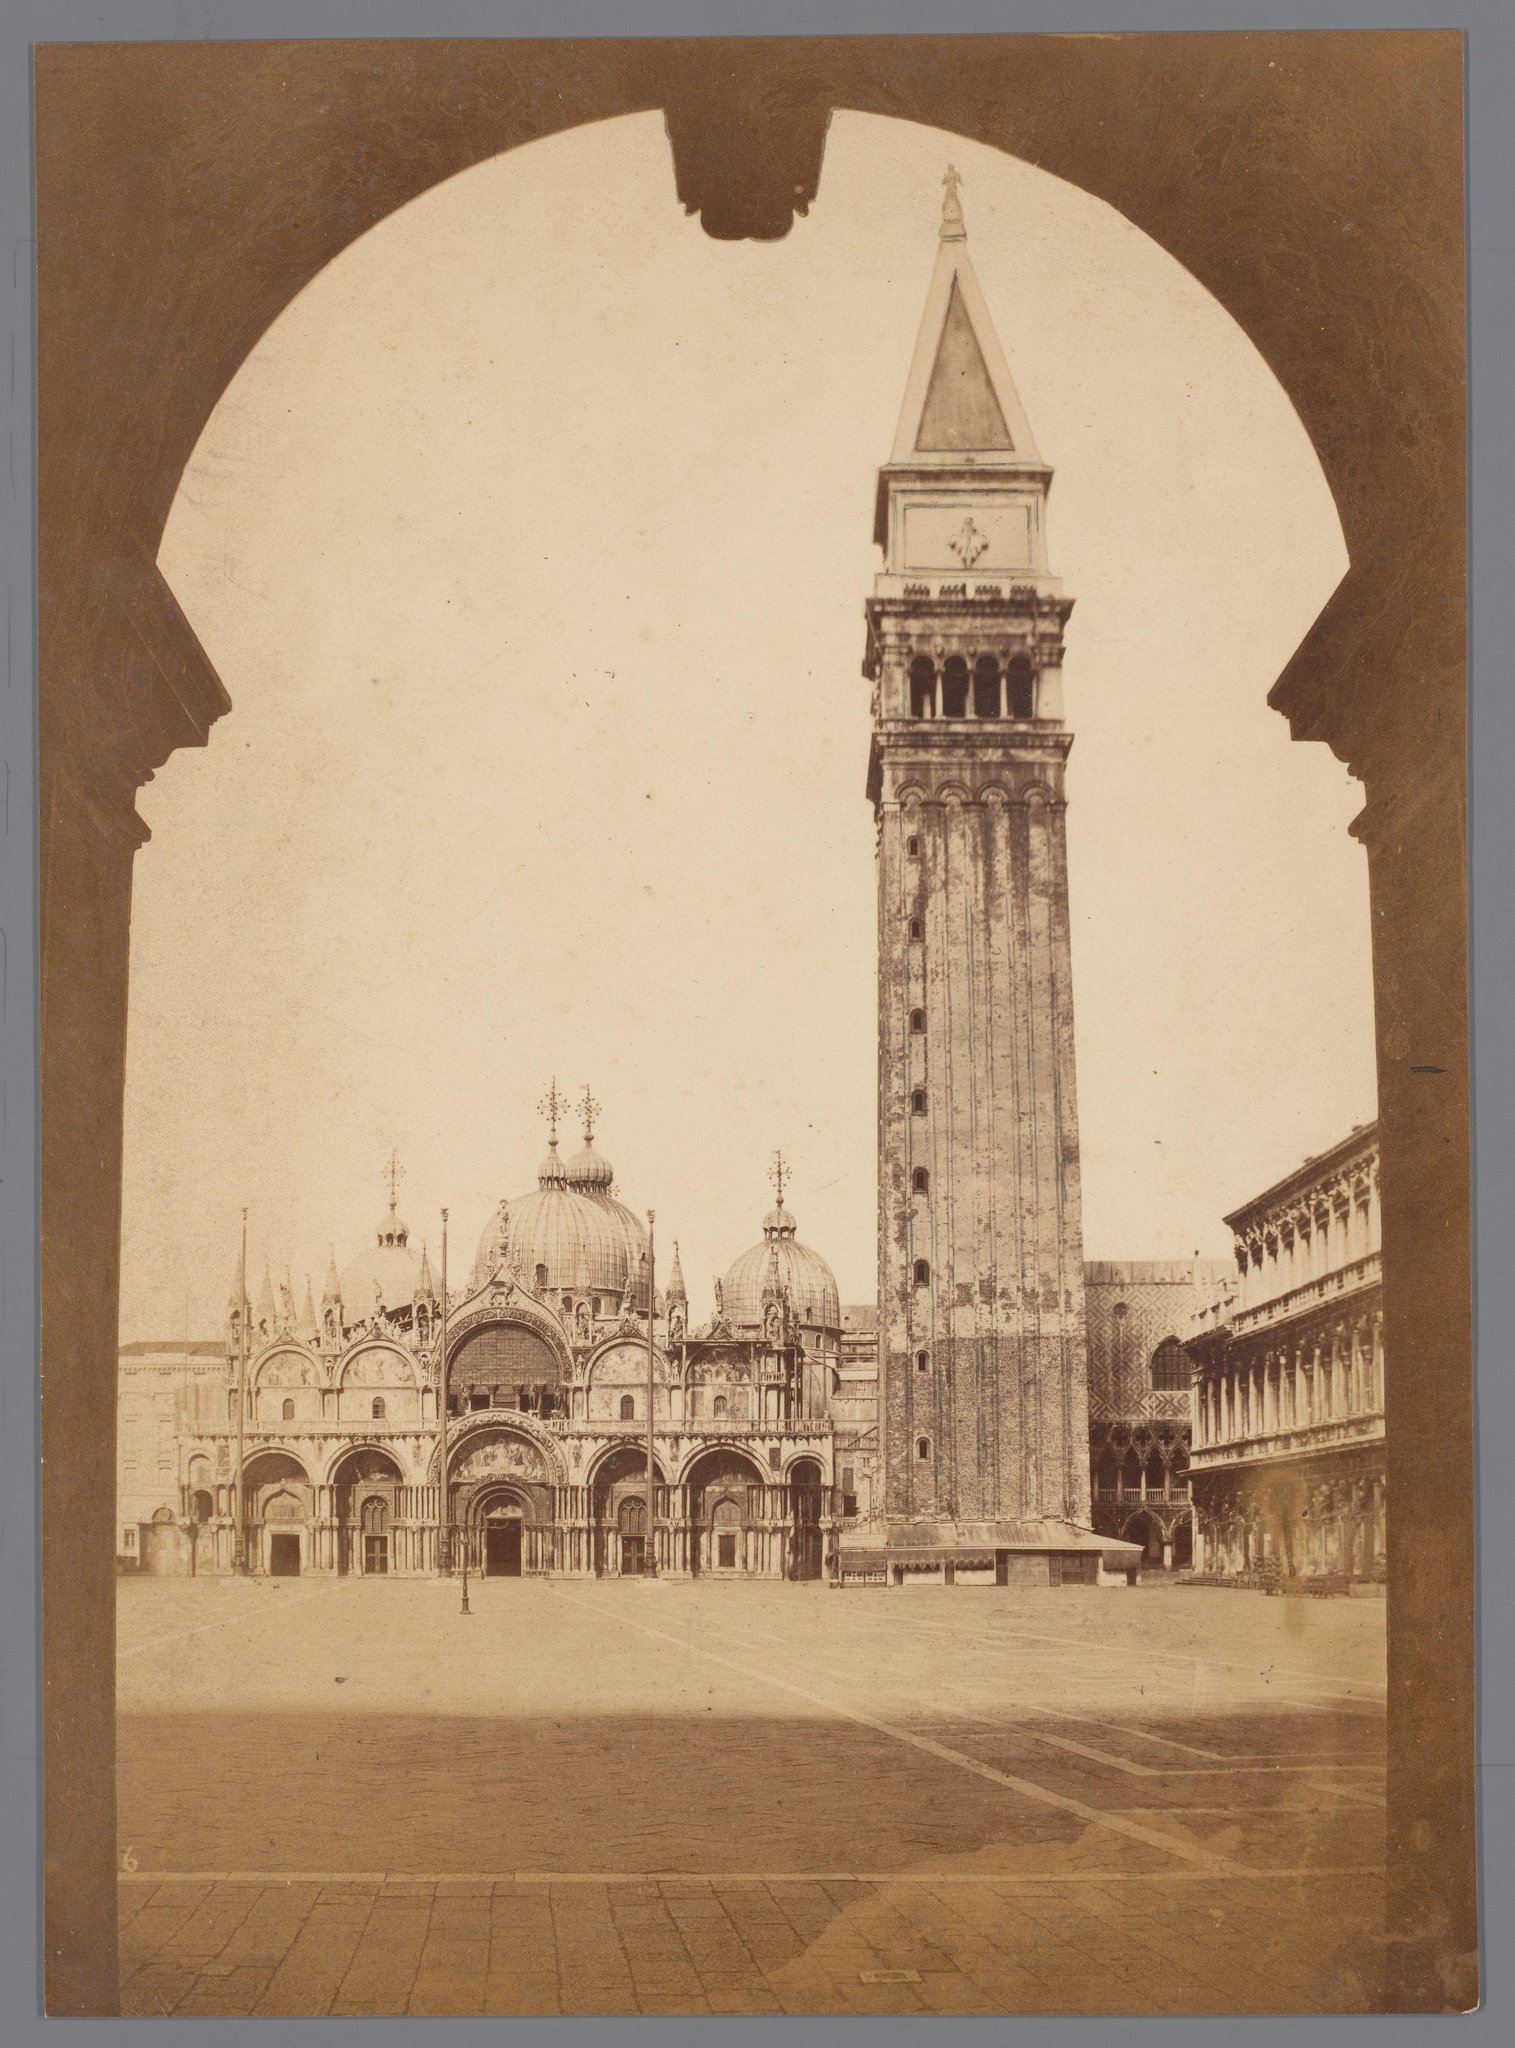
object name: photograph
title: Piazza di S. Marco dal Palazzo Reale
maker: carlo naya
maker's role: fotograaf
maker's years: 1816-1882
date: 1857-1882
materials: cardboard, paper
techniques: albumen print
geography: venice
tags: parts of church exterior and annexes: campanile, square, place, circus, etc., church (exterior)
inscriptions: number: ‘N. 5.’, number: ‘6’, inscription: ‘(t) Naya’, inscription: ‘La place St. Marc étati d'abord un jardin, qui appar-/ tenait aux religieuses de St. Zacharie. (...)’